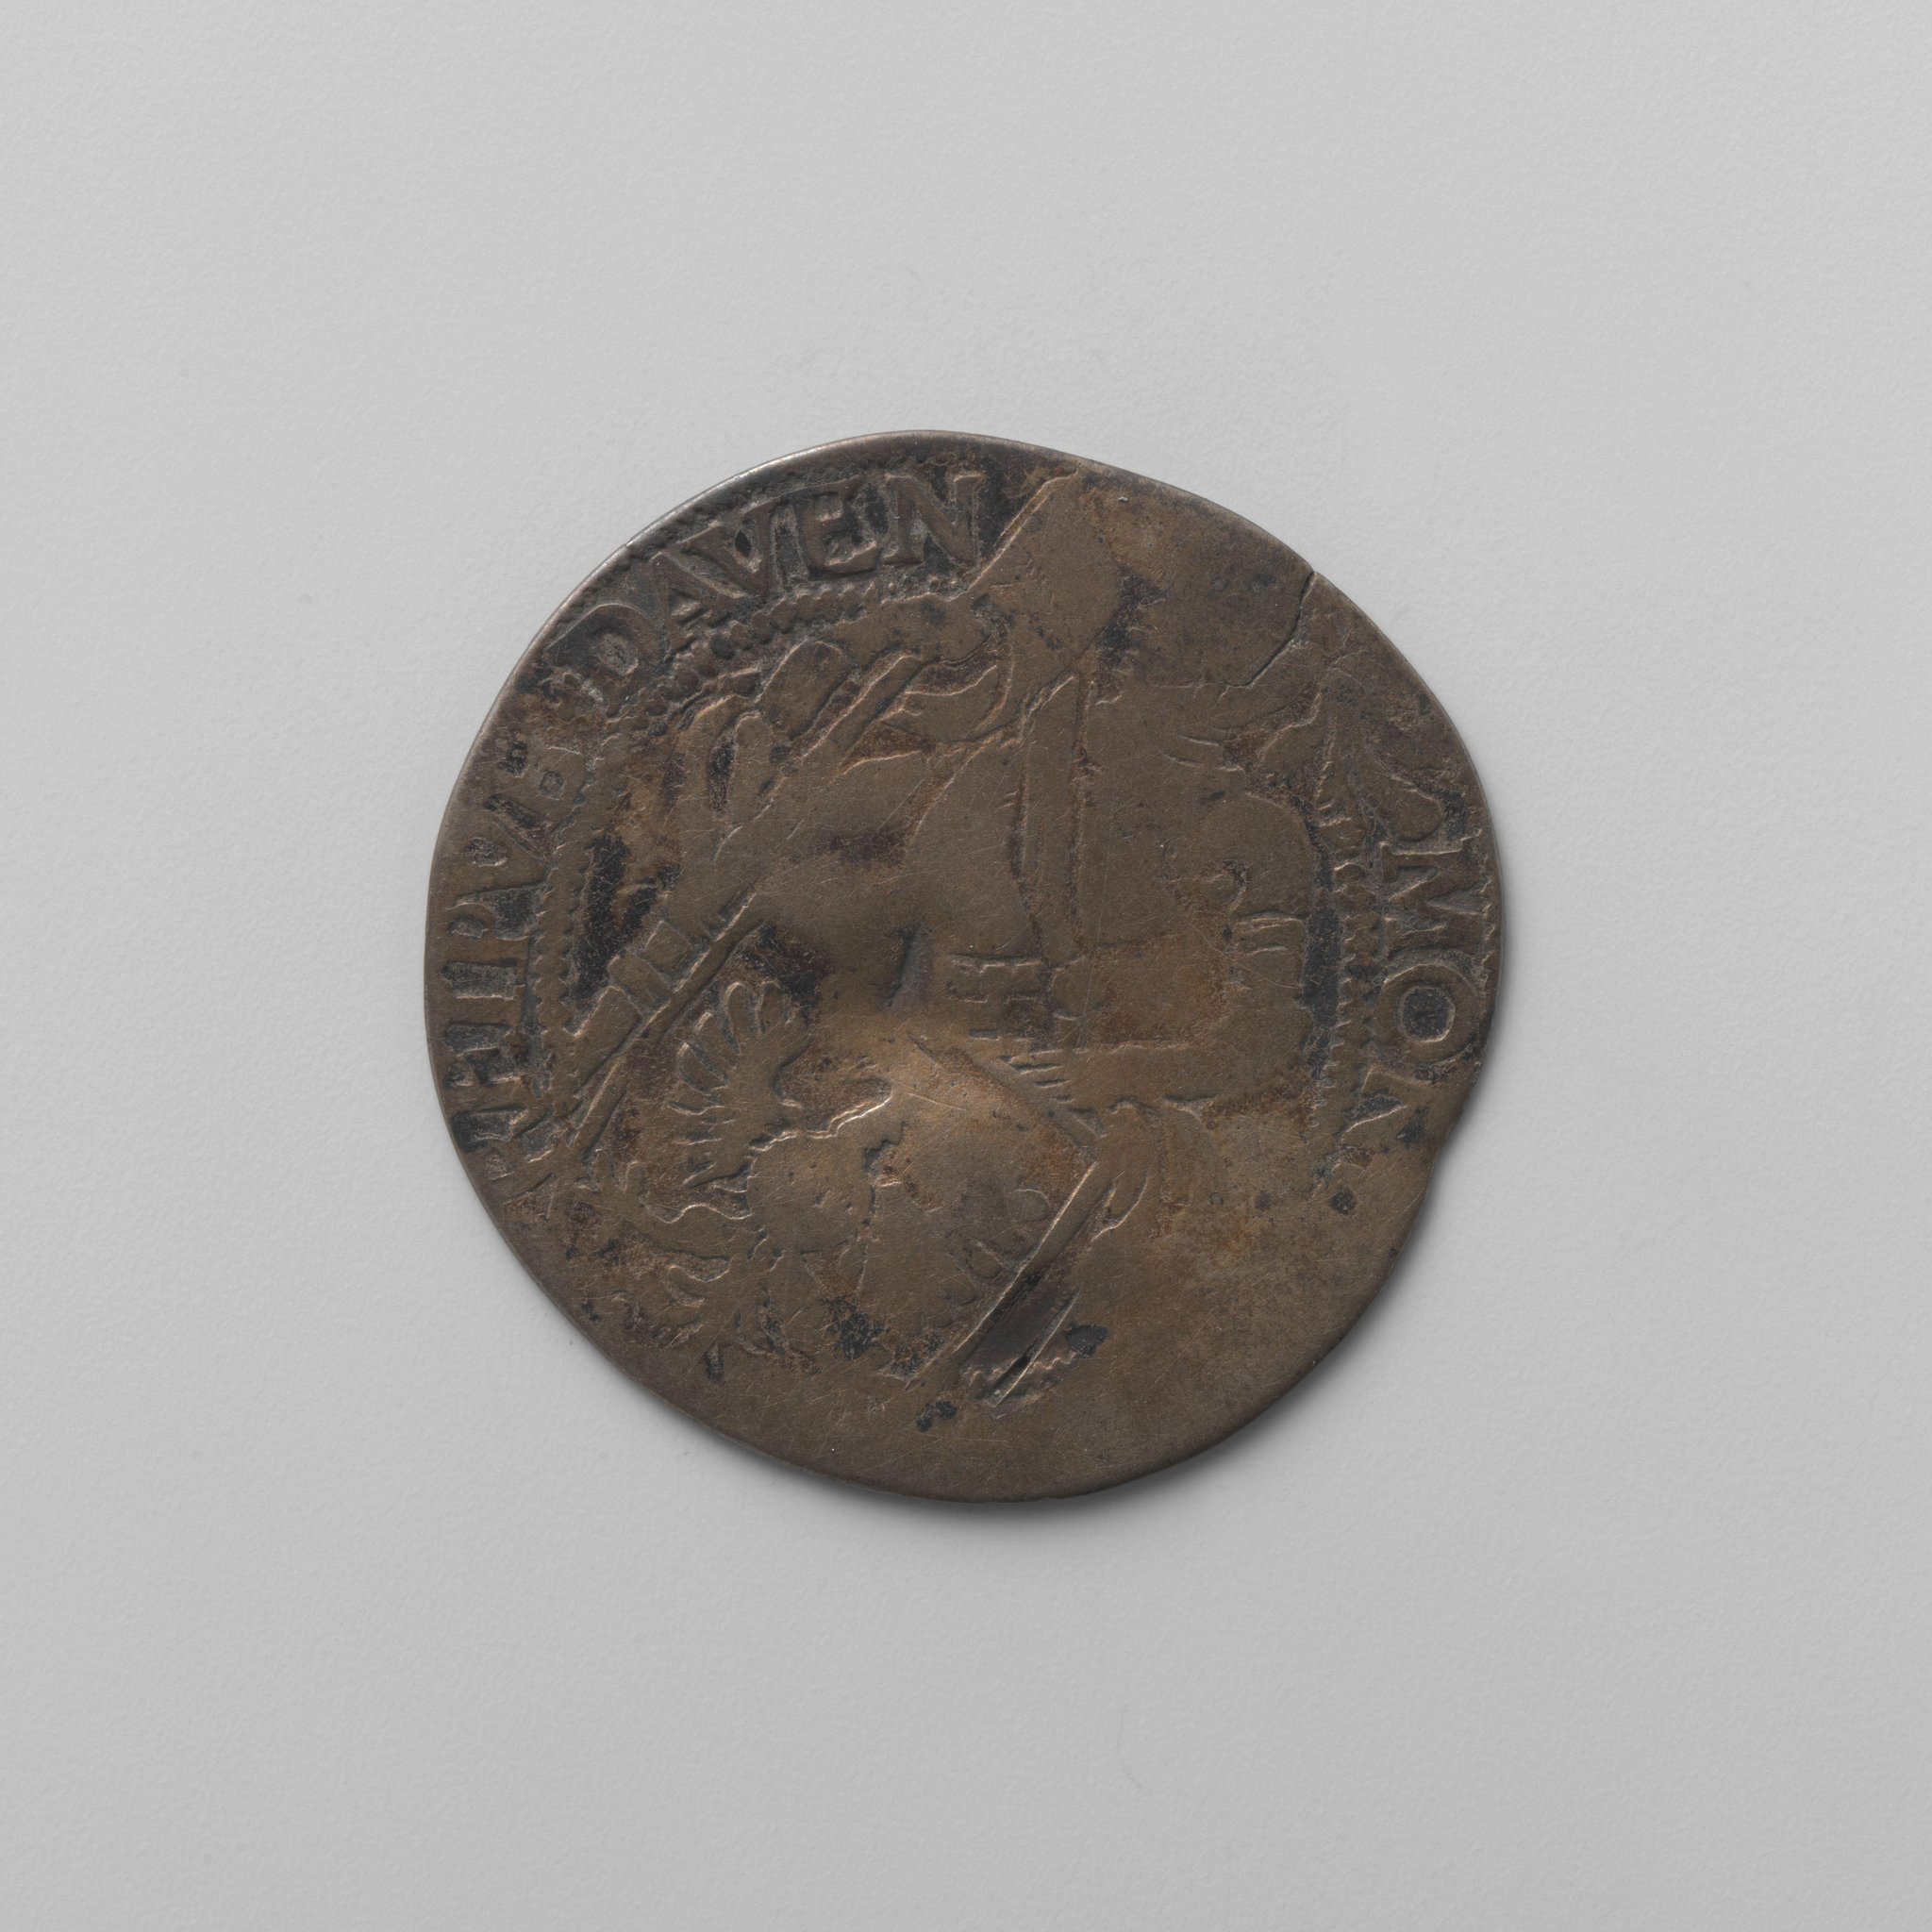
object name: coin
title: Deventer, snaphaanschelling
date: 1597-1599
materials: silver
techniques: striking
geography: deventer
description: Zilveren munt. Voorzijde: staande geharnaste halve man naar links met vaan, waaronder wapenschild van Deventer. Keerzijde: op lang versierd kruis gekroond wapenschild van Deventer.